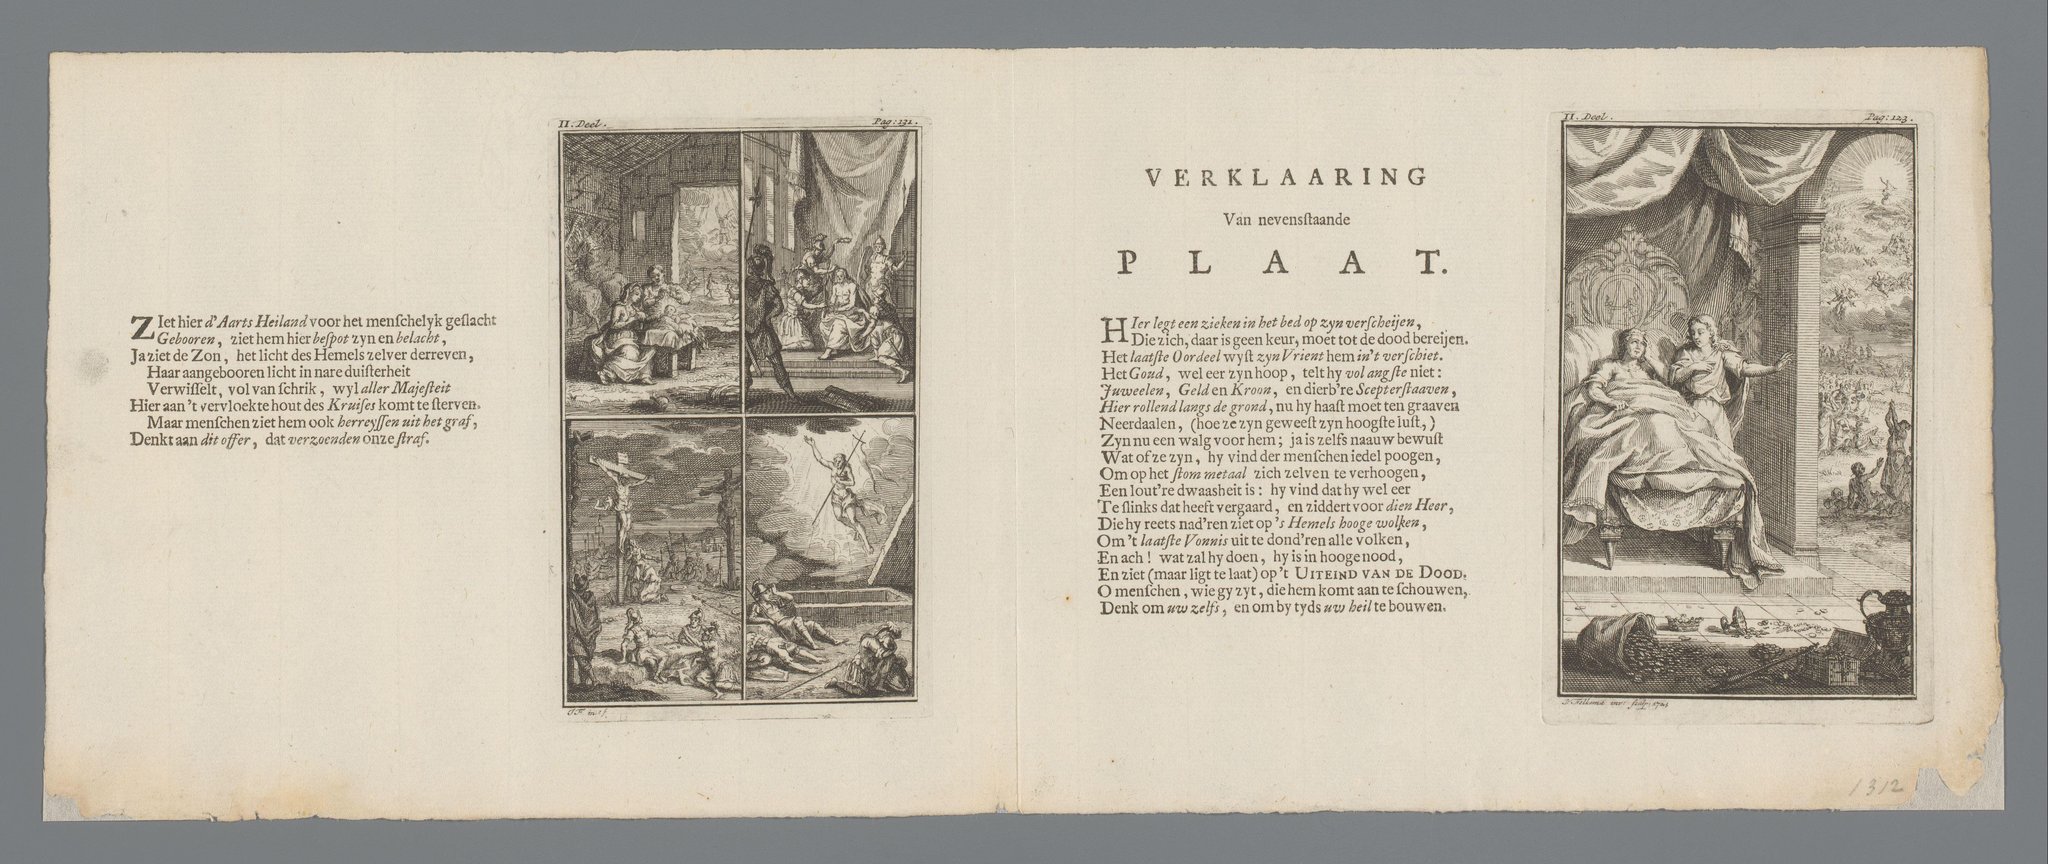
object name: book illustration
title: Rijke man op zijn sterfbed maakt zich klaar voor het Laatste Oordeel (rechter plaat)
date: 1723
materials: paper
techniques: etching, letterpress printing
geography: amsterdam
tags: last judgement, deathbed, resurrection of christ, birth and youth of christ, the crucifixion of christ: christ's death on the cross; golgotha (matthew 27:45-58; mark 15:33-45; luke 23:44-52; john 19:25-38), mockings of christ, who may be blindfolded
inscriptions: watermark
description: Proefdrukken voor: Roeland van Leuve. Roeland van Leuve's Mengelwerken. Amsterdam: Jacobus Verheyden, 1723.